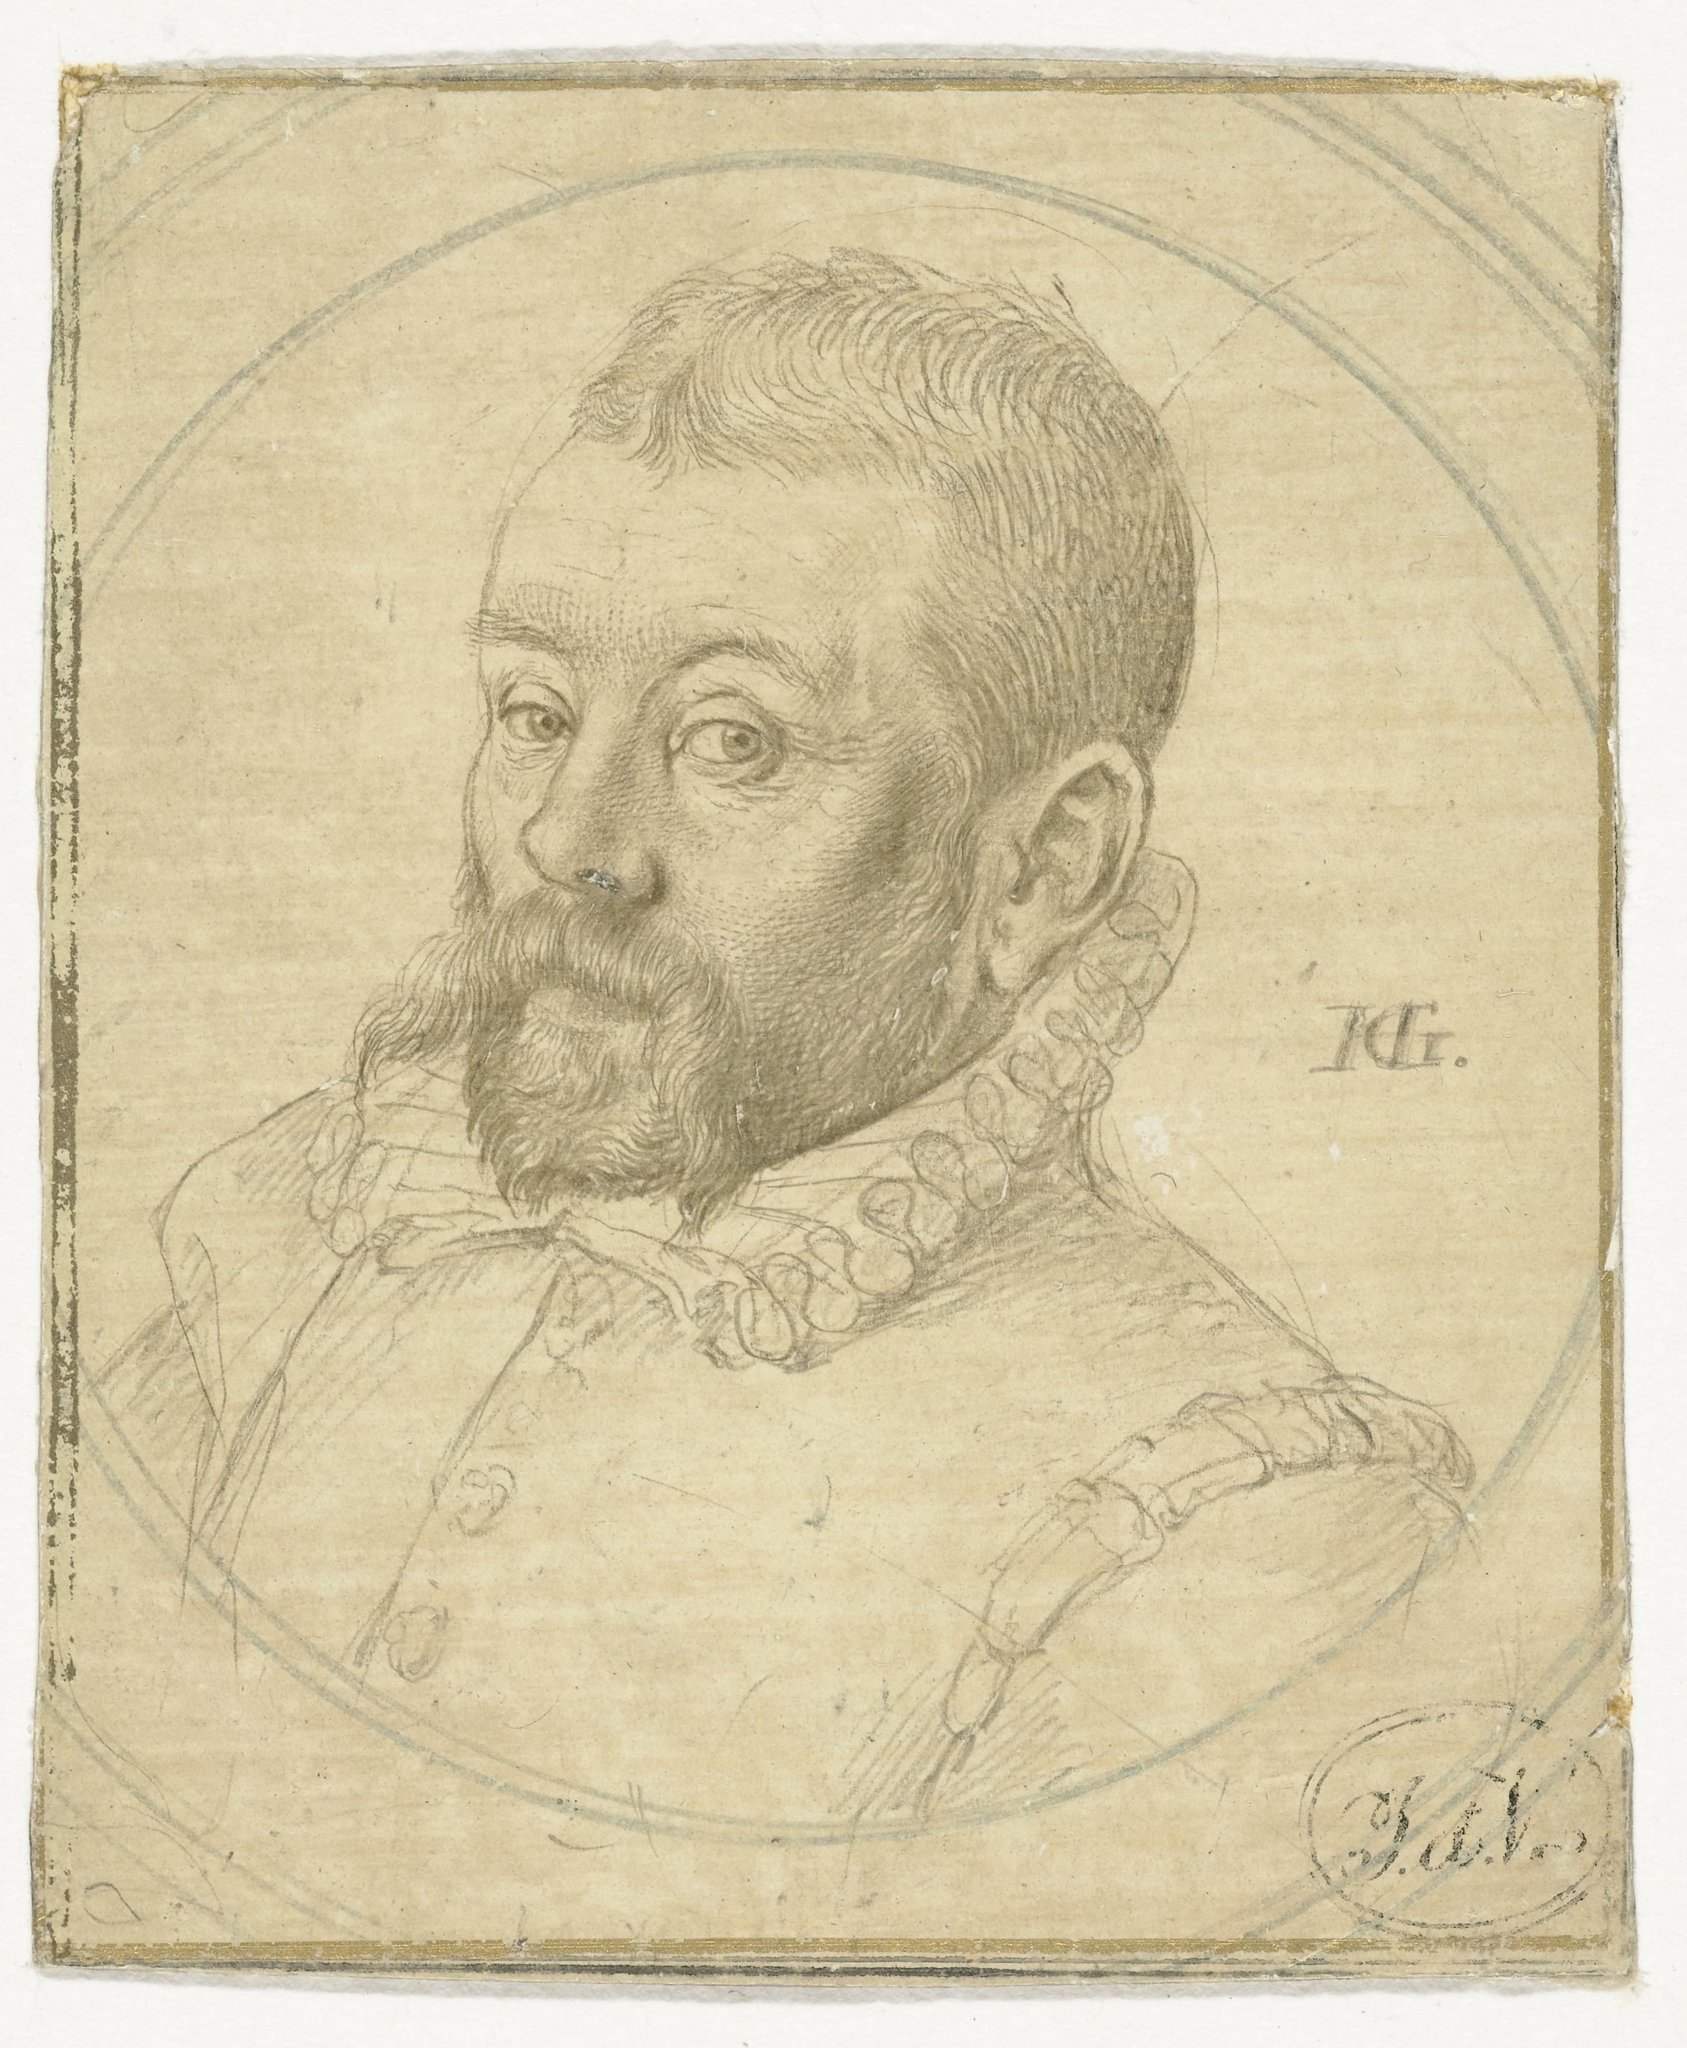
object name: drawing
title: Portret van Lubbert Claesz. van der Weijden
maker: hendrick goltzius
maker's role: draughtsman, painter, print maker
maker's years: 1558-1617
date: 1590-1599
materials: paper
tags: historical persons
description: Reznicek bevestigd dat de inscriptie op de verso van Goltzius is; in ieder geval is het een 17e eeuws handschrift, zodat aan de identificatie nauwelijks getwijfeld kan worden. Hij verondersteld echter, dat de geportretteerde niet Claes Lubbertsz. van de Weijden is maar mogelijk zijn vader, Lubbert Claesz. van de Weijden die in 1626 burgemeester van Haarlem was. De datum, 1586, toegevoegd door Ploos, en de naam van de geportretteerde kwamen al voor in de Muilman catalogus. Daarom lijkt de datering betrouwbaar.Volgens de informatie vriendelijk geleverd door T.N. Schelhaus, assistent-archivaris te Haarlem, Claes Lubbertsz van de Weyden, eigenaar van de Haarlemse brouwerij 'de Winthont' was in 1658 te Haarlem begraven. Lubbert Claesz, waarschijnlijk zijn vader, was reeds in 1618 lid van de Haarlemse gemeenteraad. Indien hij de geportretteerde is, dan is dit portret gedateerd in de jaren negentig en niet in 1586.